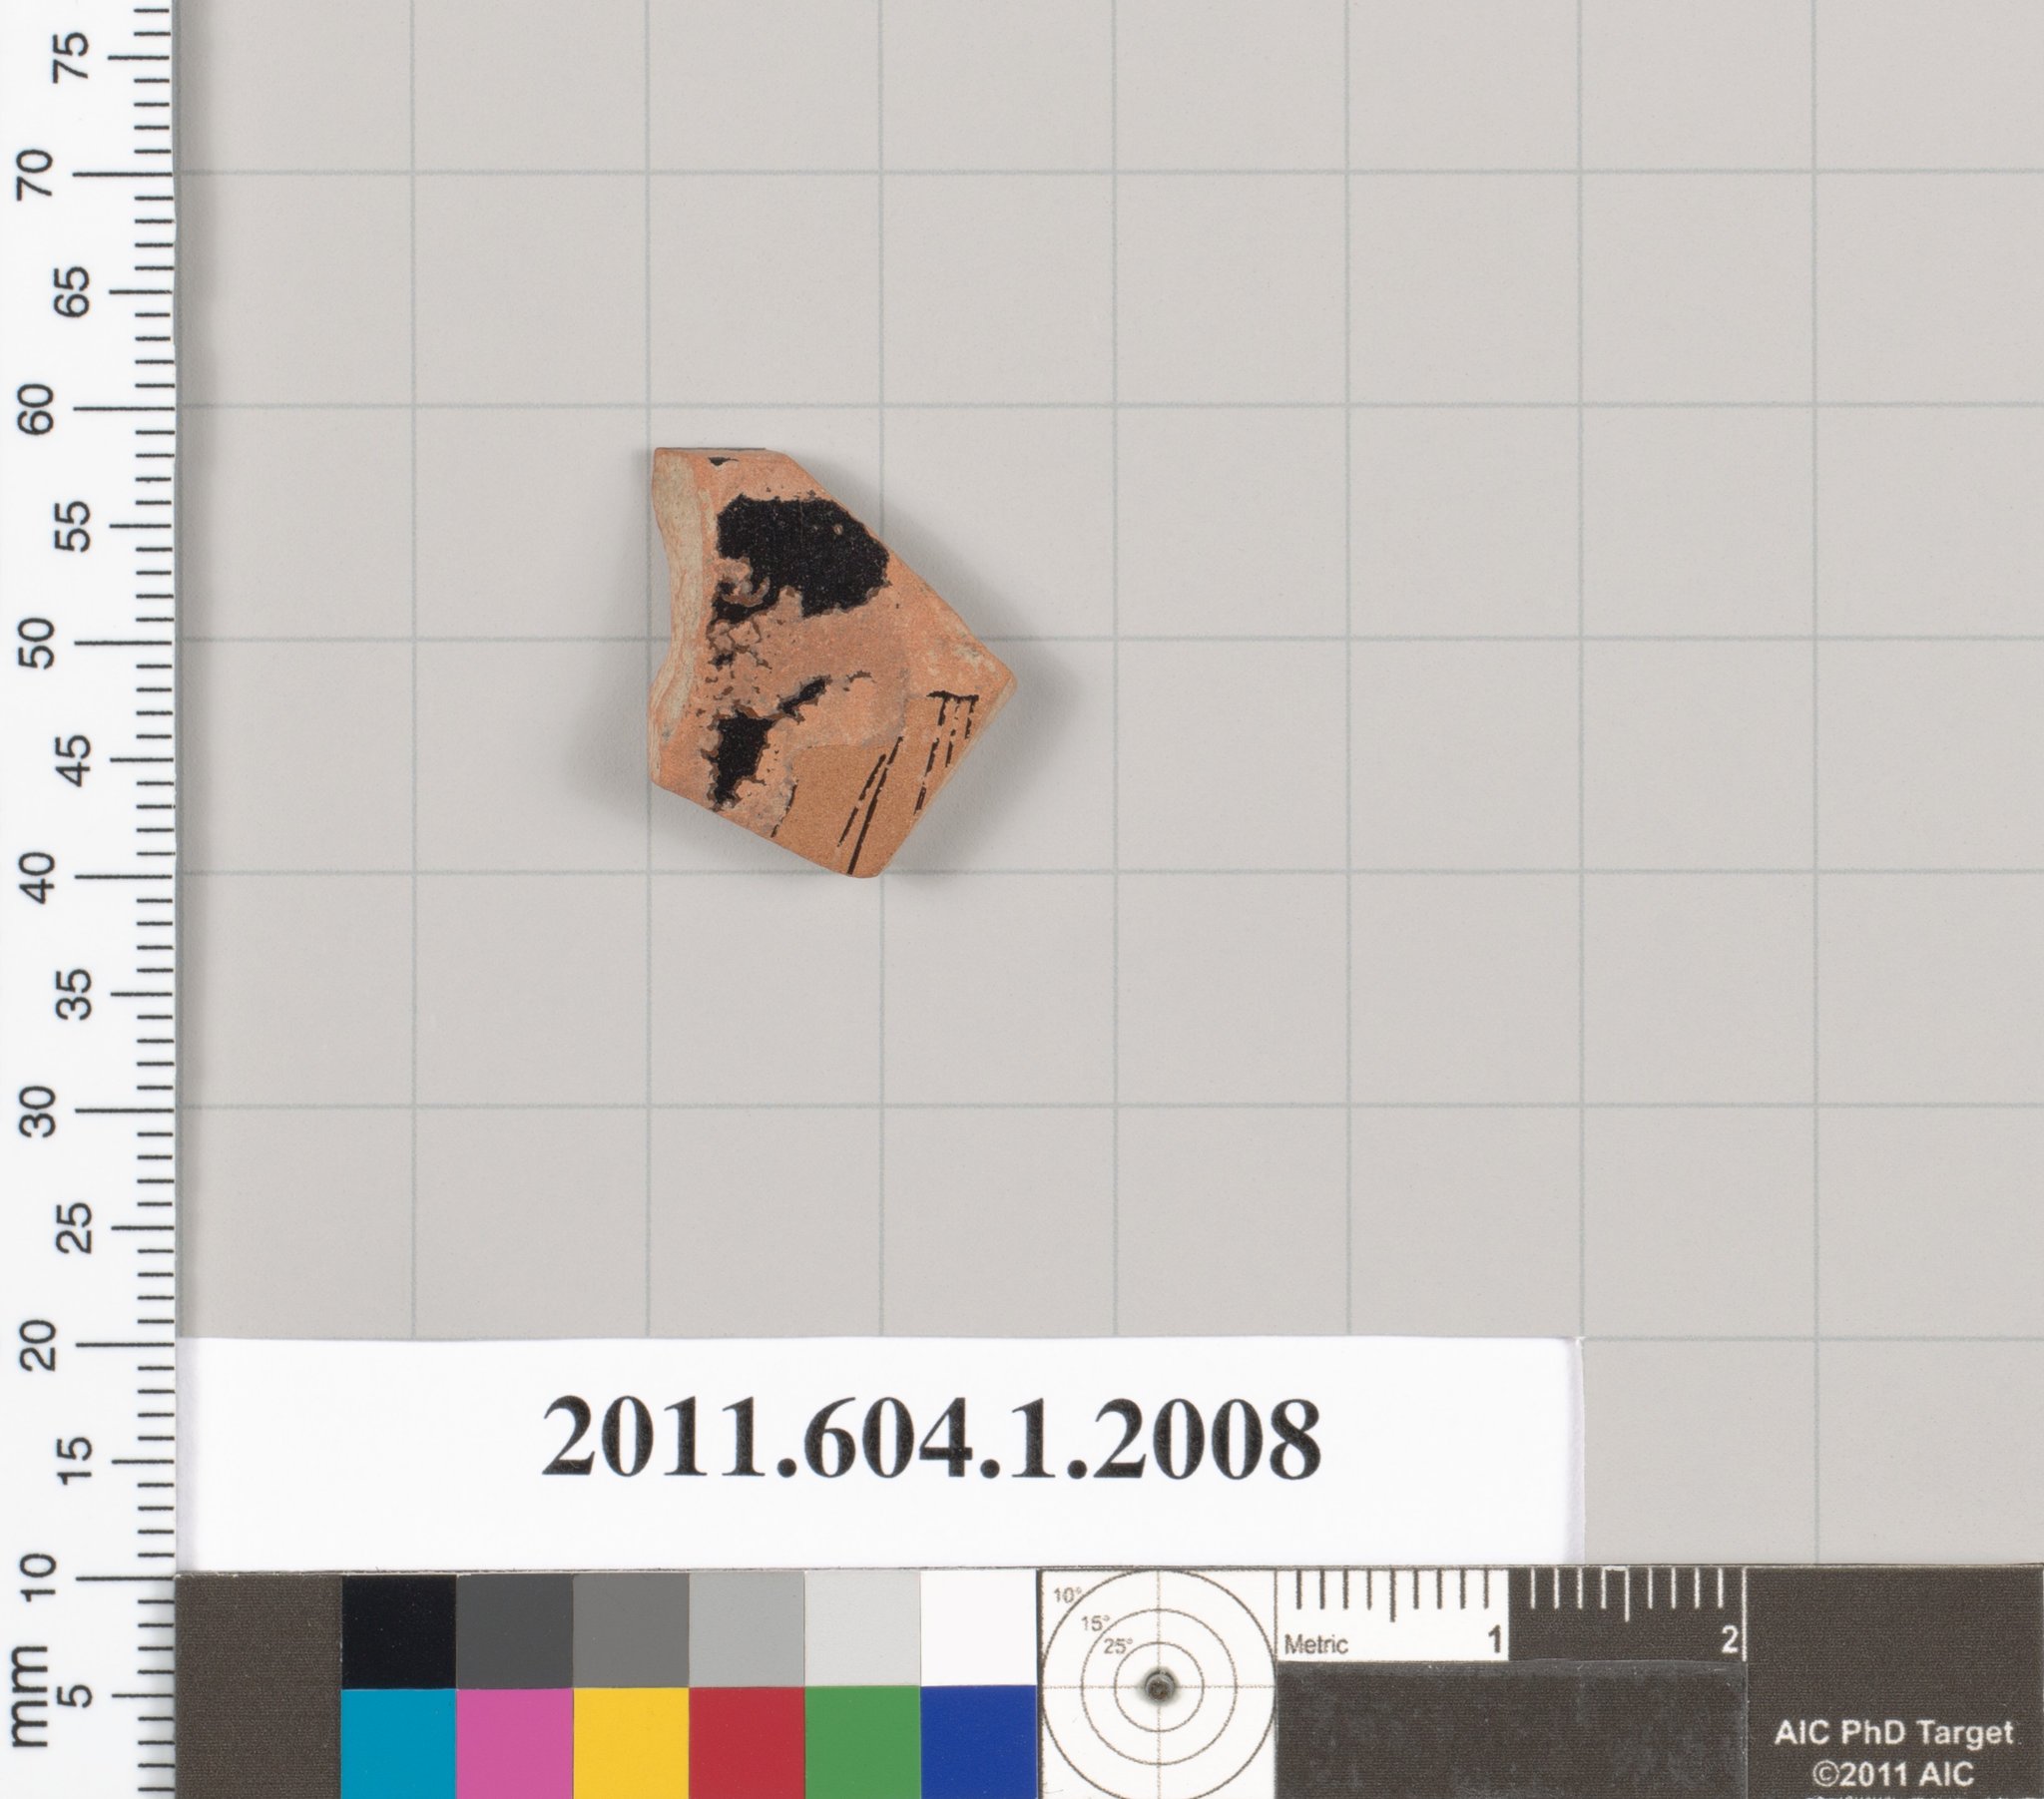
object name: kylix fragment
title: Terracotta rim fragment of a kylix (drinking cup)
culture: greek, attic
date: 500-476 BCE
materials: terracotta